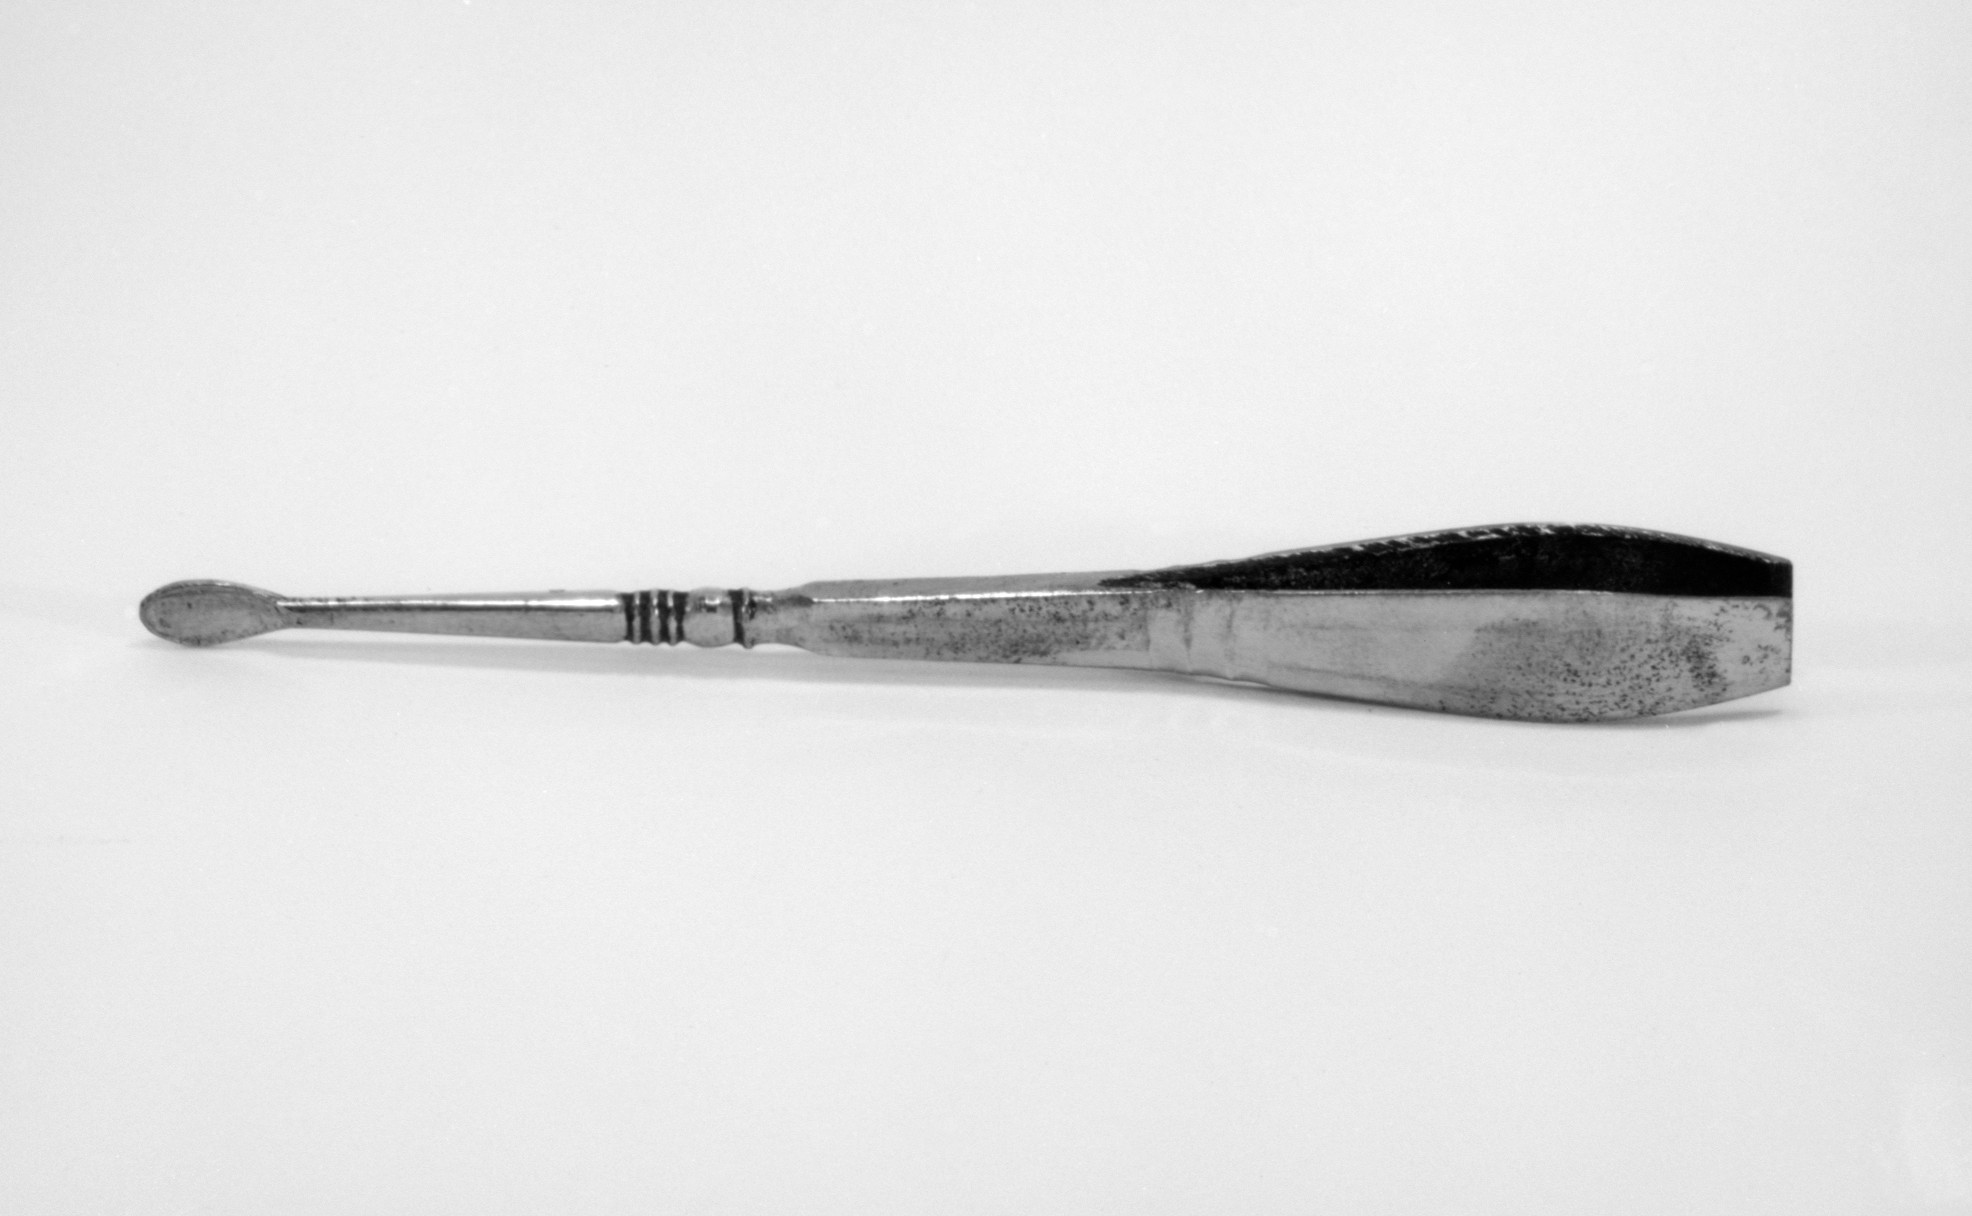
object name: tweezer and ear spoon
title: Tweezers and ear spoon (part of a set)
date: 1848-1849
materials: steel